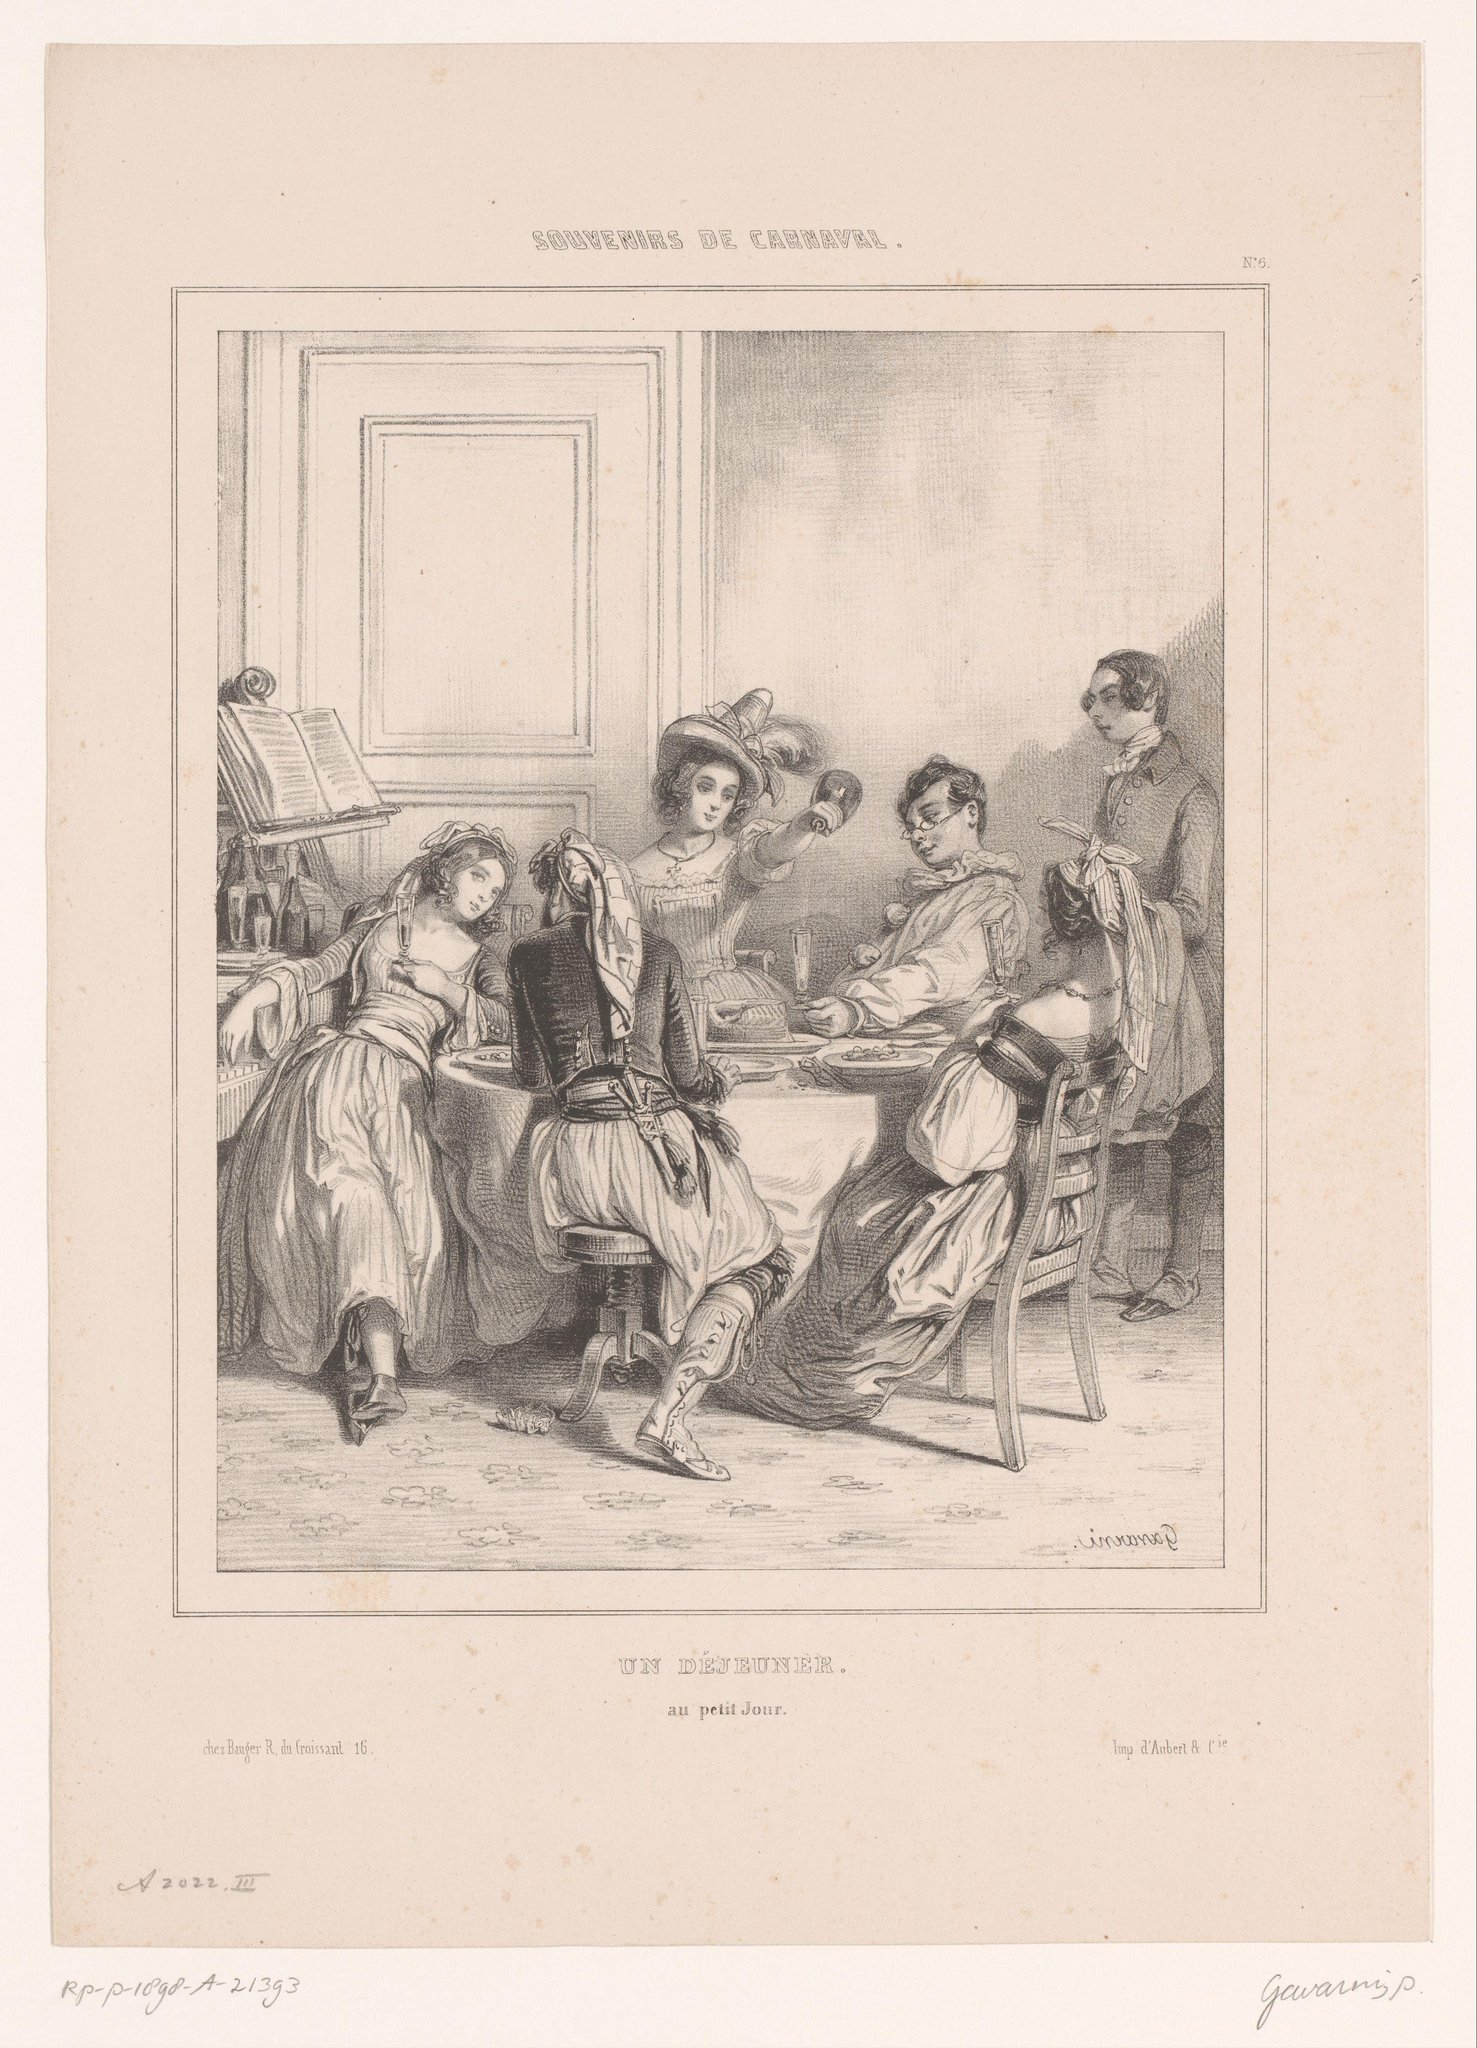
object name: print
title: Souvenirs de Carnaval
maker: paul gavarni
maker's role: draughtsman, print maker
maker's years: 1804-1866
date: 1840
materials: paper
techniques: lithograph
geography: paris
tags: breakfast, carnival, shrovetide (non-liturgical celebration), drinking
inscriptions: collector's mark: Lugt 964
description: Prent gebruikt voor: La Caricature, 26 april 1840.